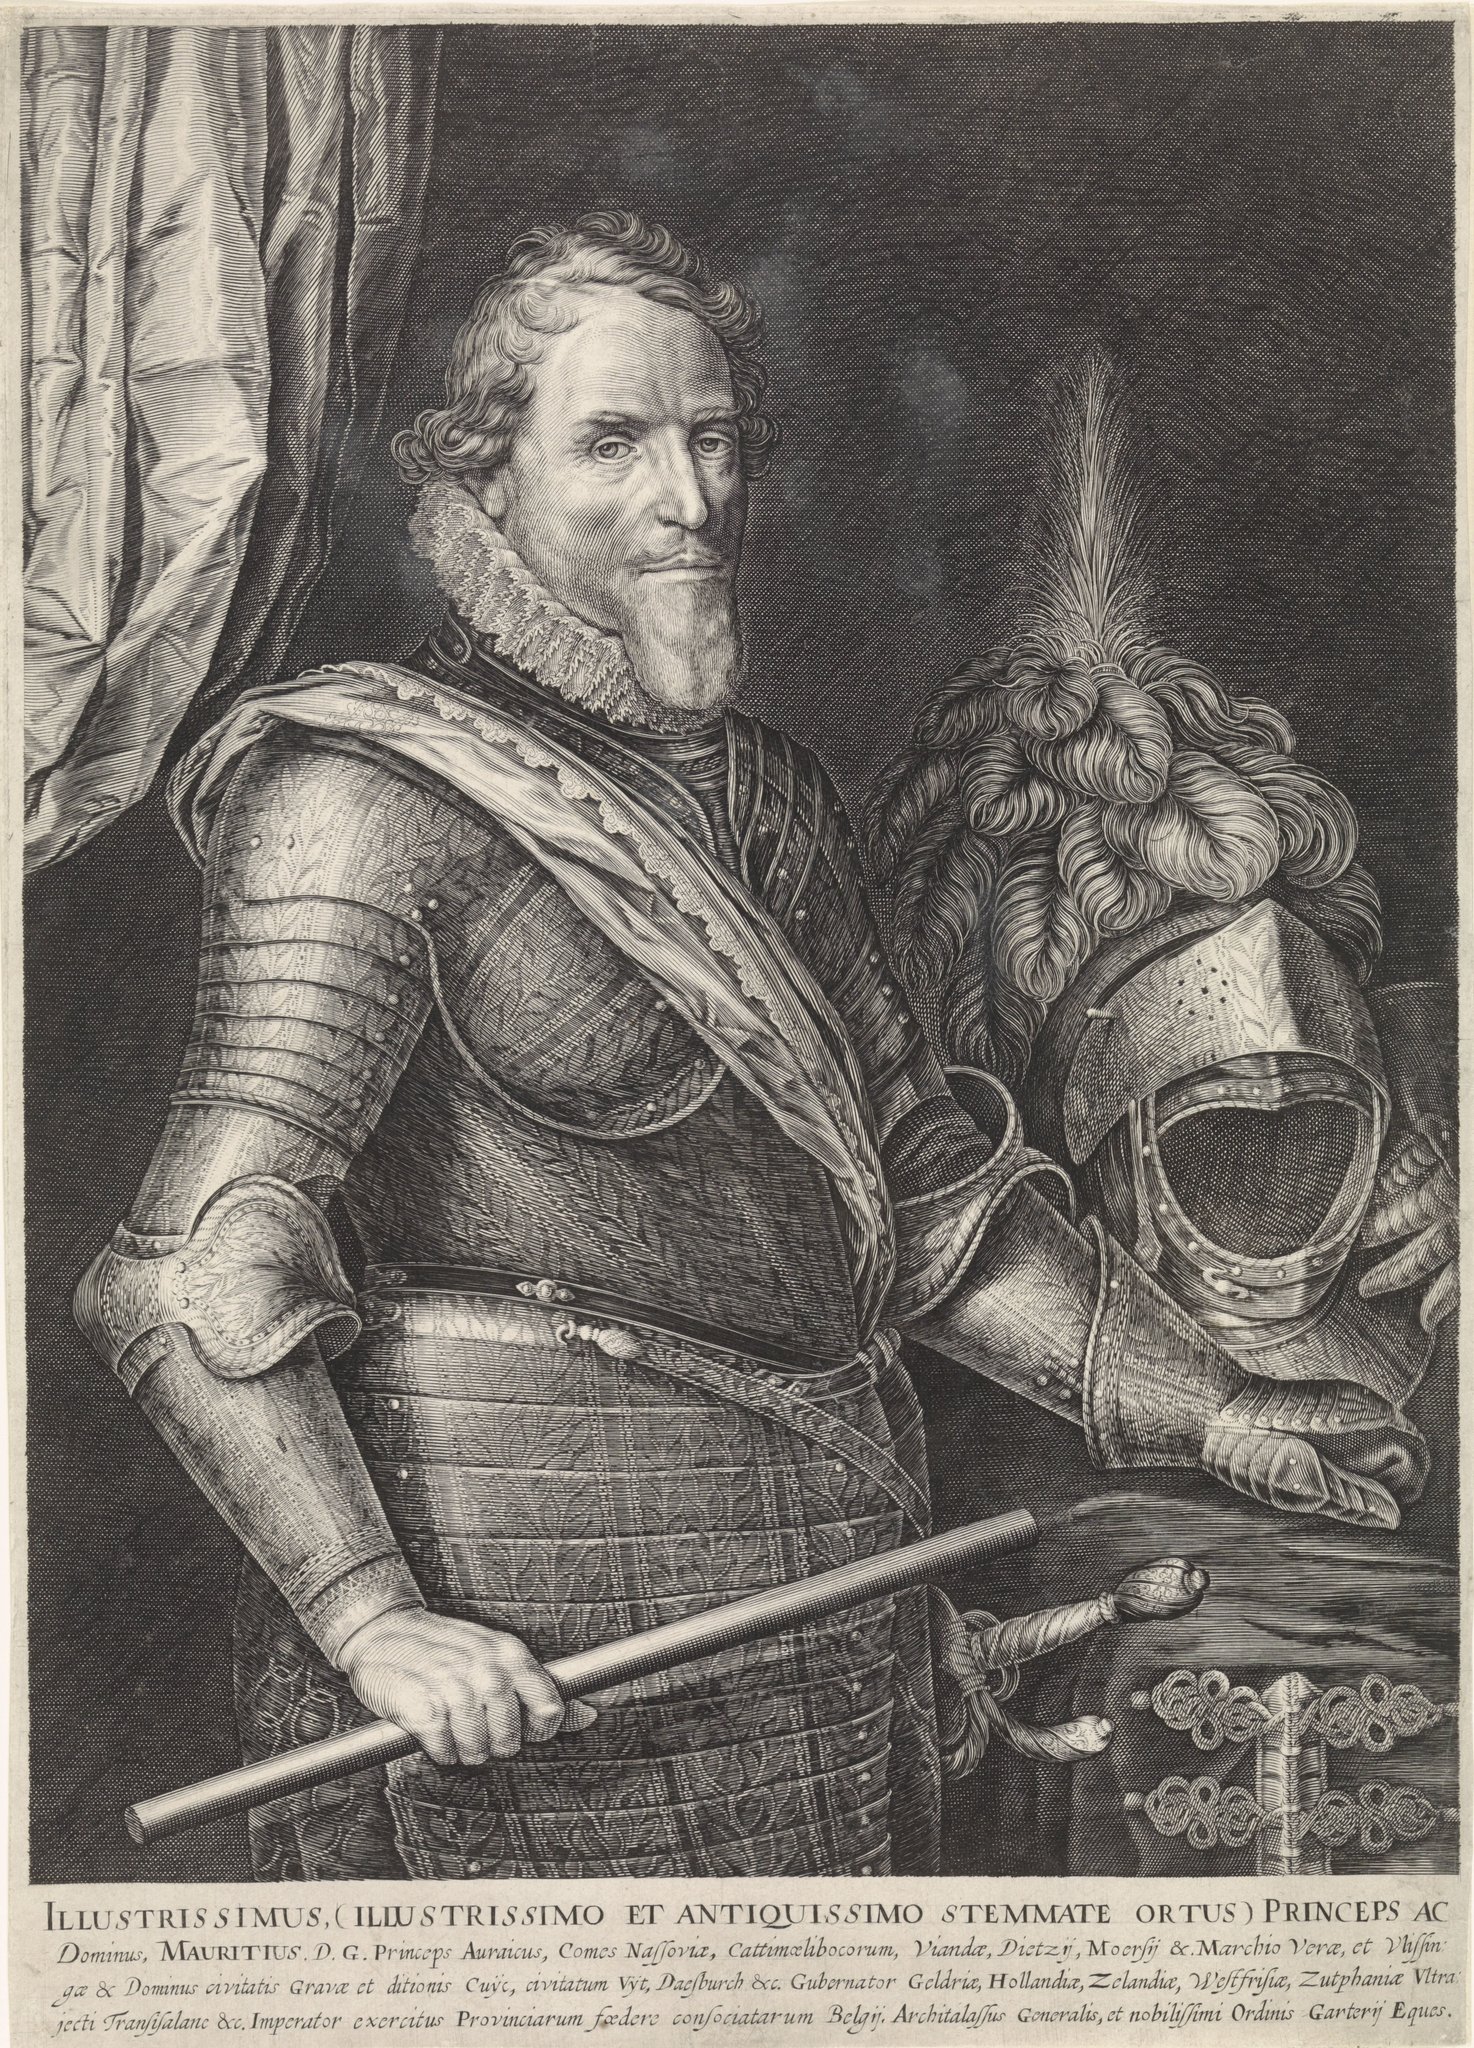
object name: print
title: Portret van prins Maurits van Oranje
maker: Anonymous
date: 1608-1678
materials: paper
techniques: engraving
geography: amsterdam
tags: the hague, maurice (prince of orange), helmet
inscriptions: collector's mark: Lugt 2228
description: Portret van Maurits, prins van Oranje, gekleed in harnas met een bevelhebbersstaf in zijn hand. Rechts op tafel zijn helm. Onderaan in de marge een vierregelige tekst in het Latijn.